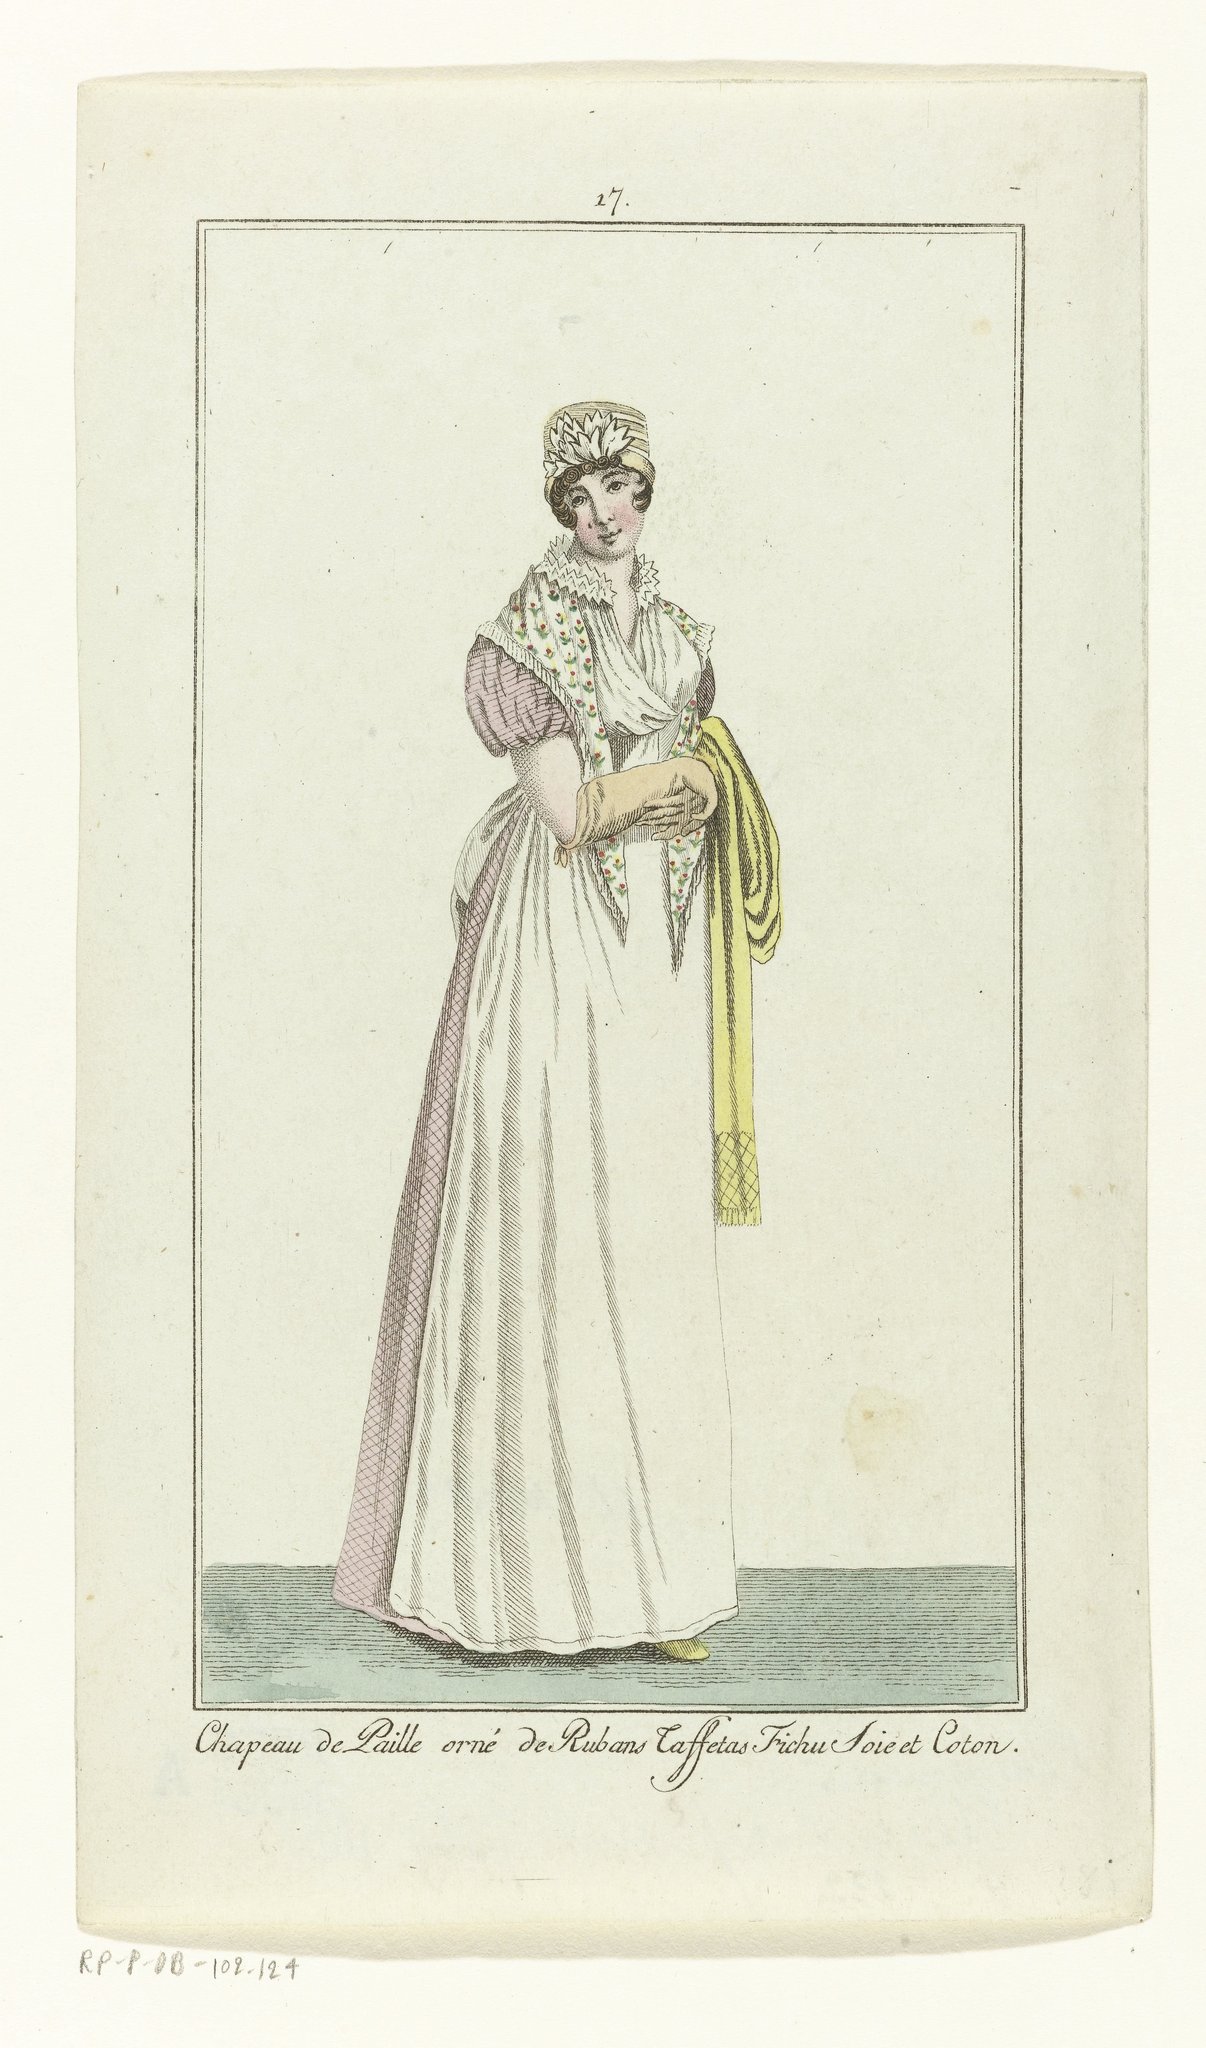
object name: fashion print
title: Elegantia, of tijdschrift van mode, luxe en smaak voor dames, Juli 1807, No. 17 : Chapeau de Paille...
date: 1807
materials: paper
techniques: engraving, hand coloring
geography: amsterdam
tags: gloves, mittens (long gloves) (+ women's clothes), clothing for the upper part of the body (shawl) (+ women's clothes), embroidery (ornamentation) (+ women's clothes), border, ribbon, braid (+ women's clothes), head-gear (straw hat) (+ women's clothes), fashion plates, dress, gown (+ women's clothes), apron (+ women's clothes), piece of clothing covering the breast or décolleté (fichu) (+ women's clothes)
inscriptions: caption: ‘Chapeau de Paille orné de Rubans Taffetas. Fichu Soie et Coton’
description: Volgens de beschrijving in het tijdschrift (p. 232): Japon van 'petite toile'. Schort van mousseline-gaas. Zijden fichu met katoen geborduurd. 'Shawl de Bagnères' (sjaal) van gele zijde. Strohoed met wit satijnen linten. Handschoenen van lichtbruin 'cabret'. Prent uit het modetijdschrift Elegantia, of tijdschrift van mode, luxe en smaak voor dames 1807-1814 (onderbroken door de periode 1811-1813).